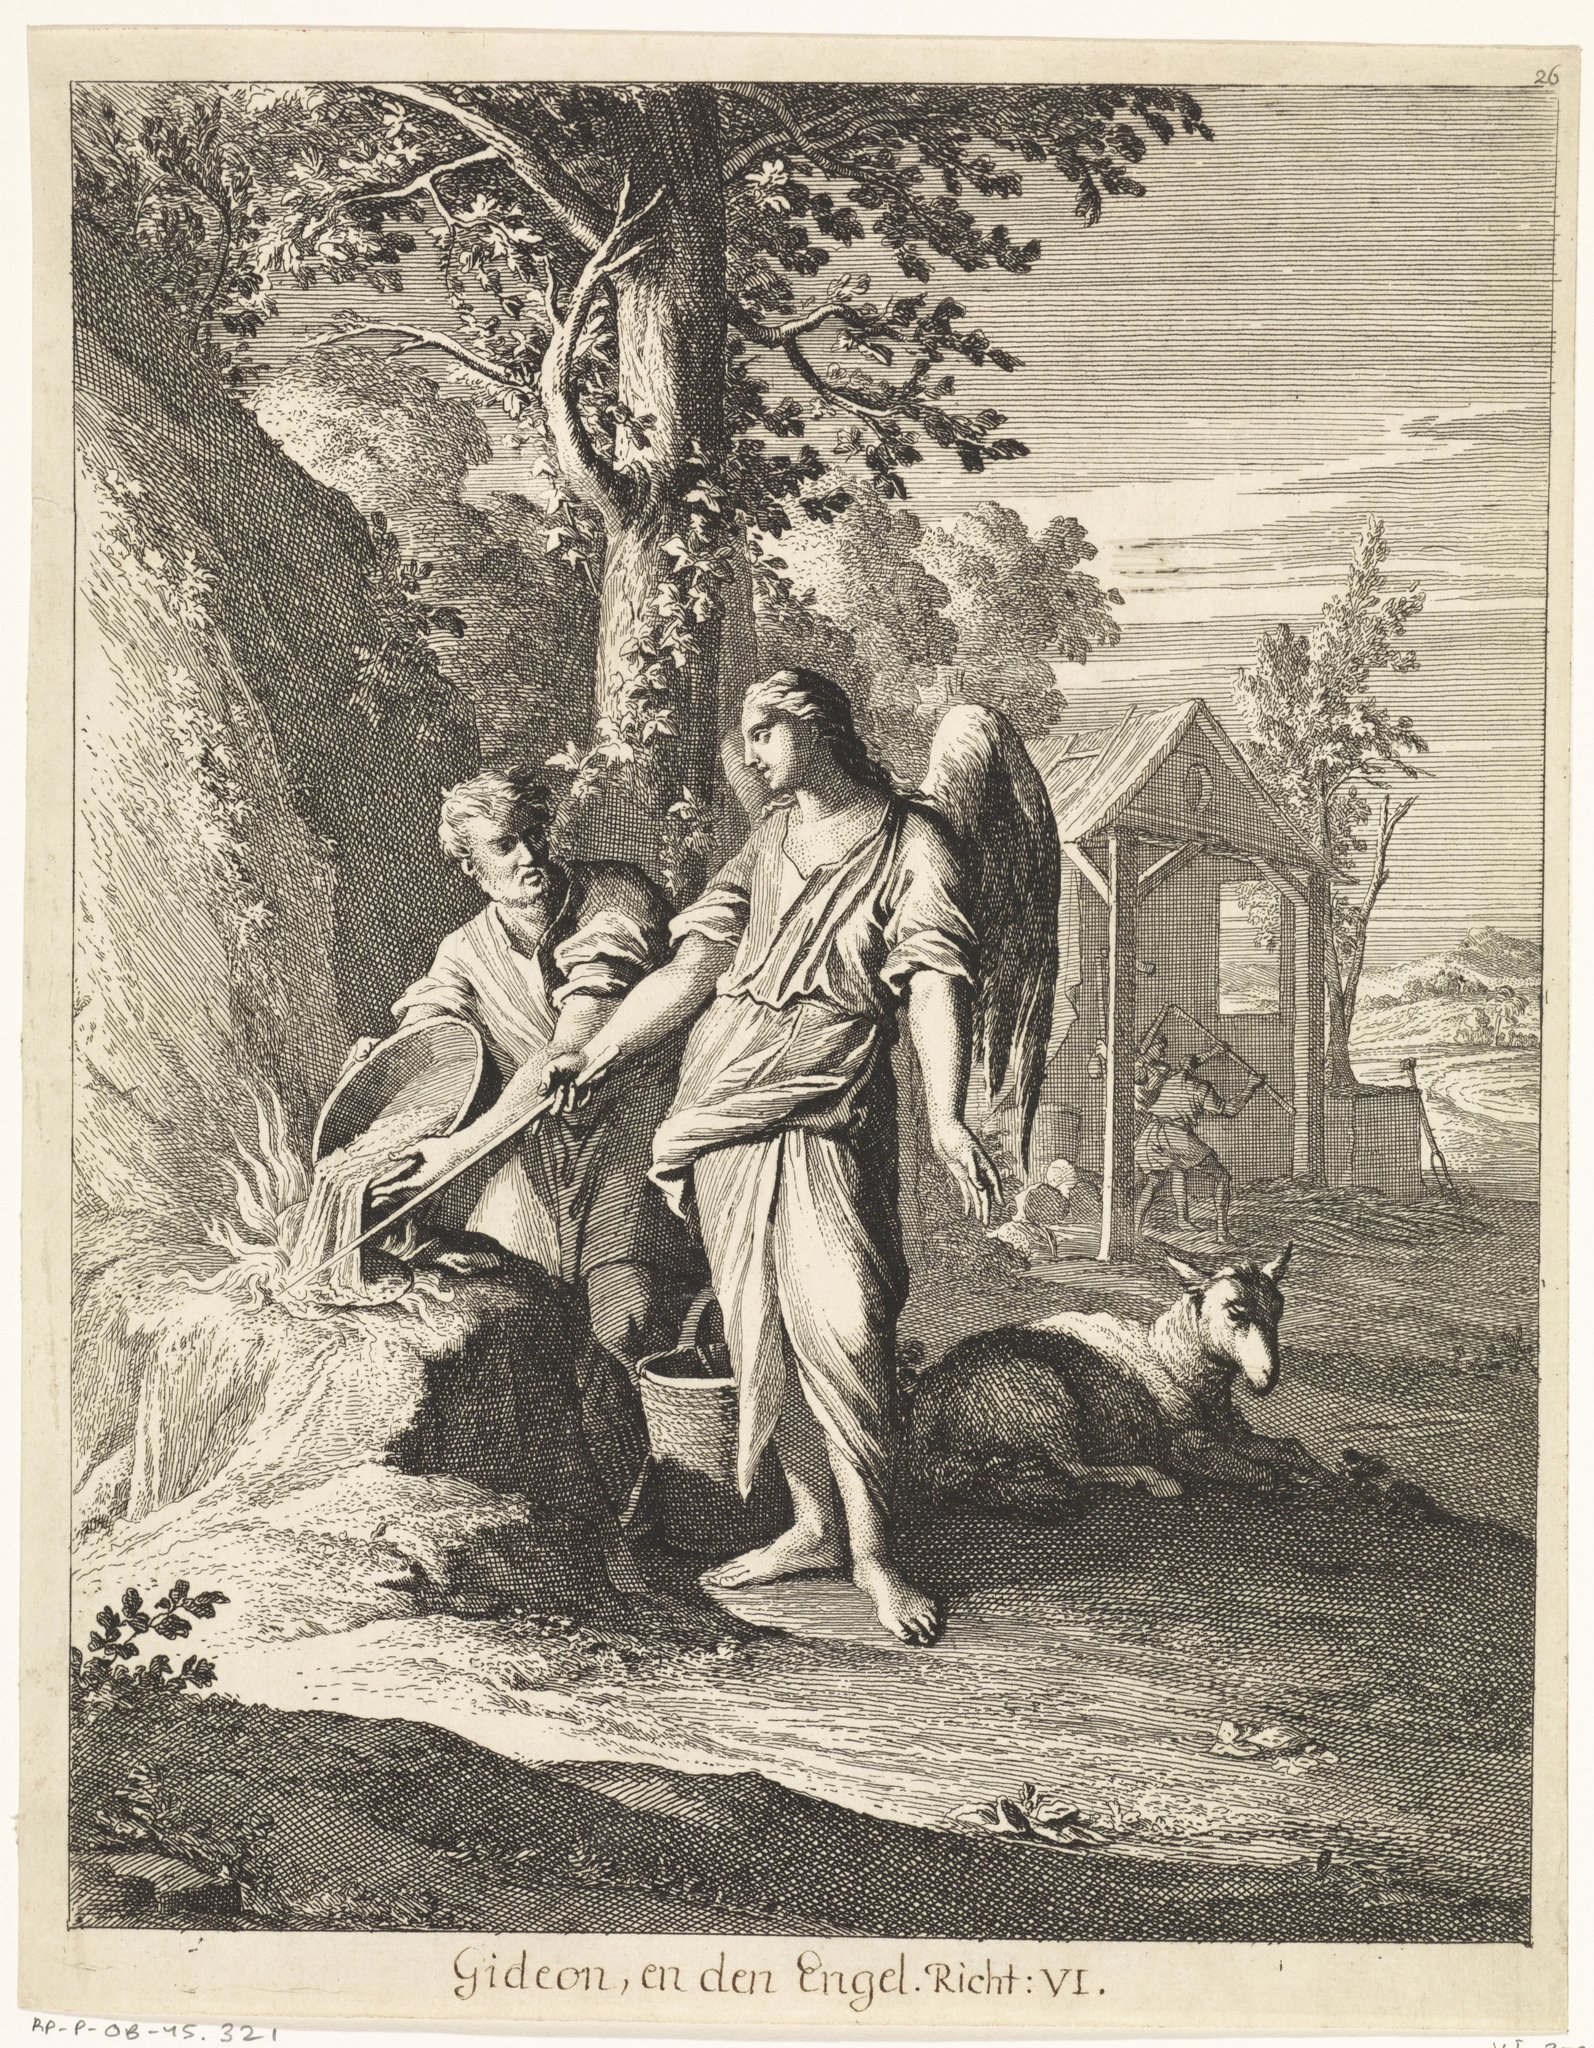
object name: print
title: Gideon en de engel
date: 1708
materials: paper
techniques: etching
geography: nuremberg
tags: at the angel's request gideon puts the food on a rock and pours out the broth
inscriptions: collector's mark: Lugt 2228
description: Proefdruk van een prent welke is opgenomen als illustratie in: Historiae Celebriores Veteris Testamenti. Christoph Weigel, 1708.